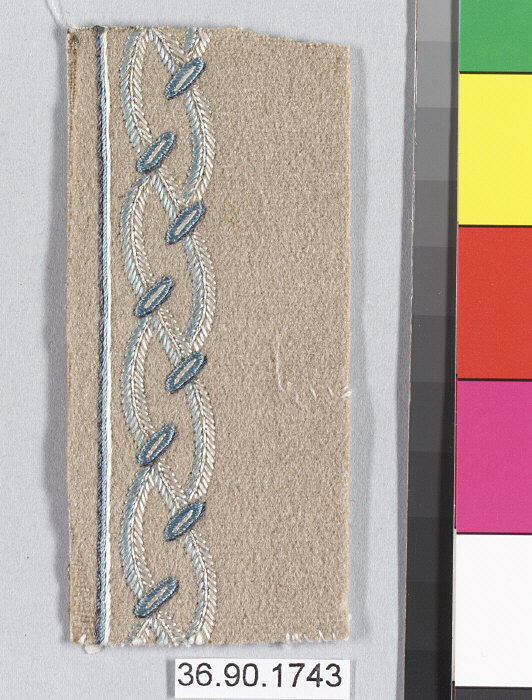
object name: sample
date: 1801-1833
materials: felt, silk